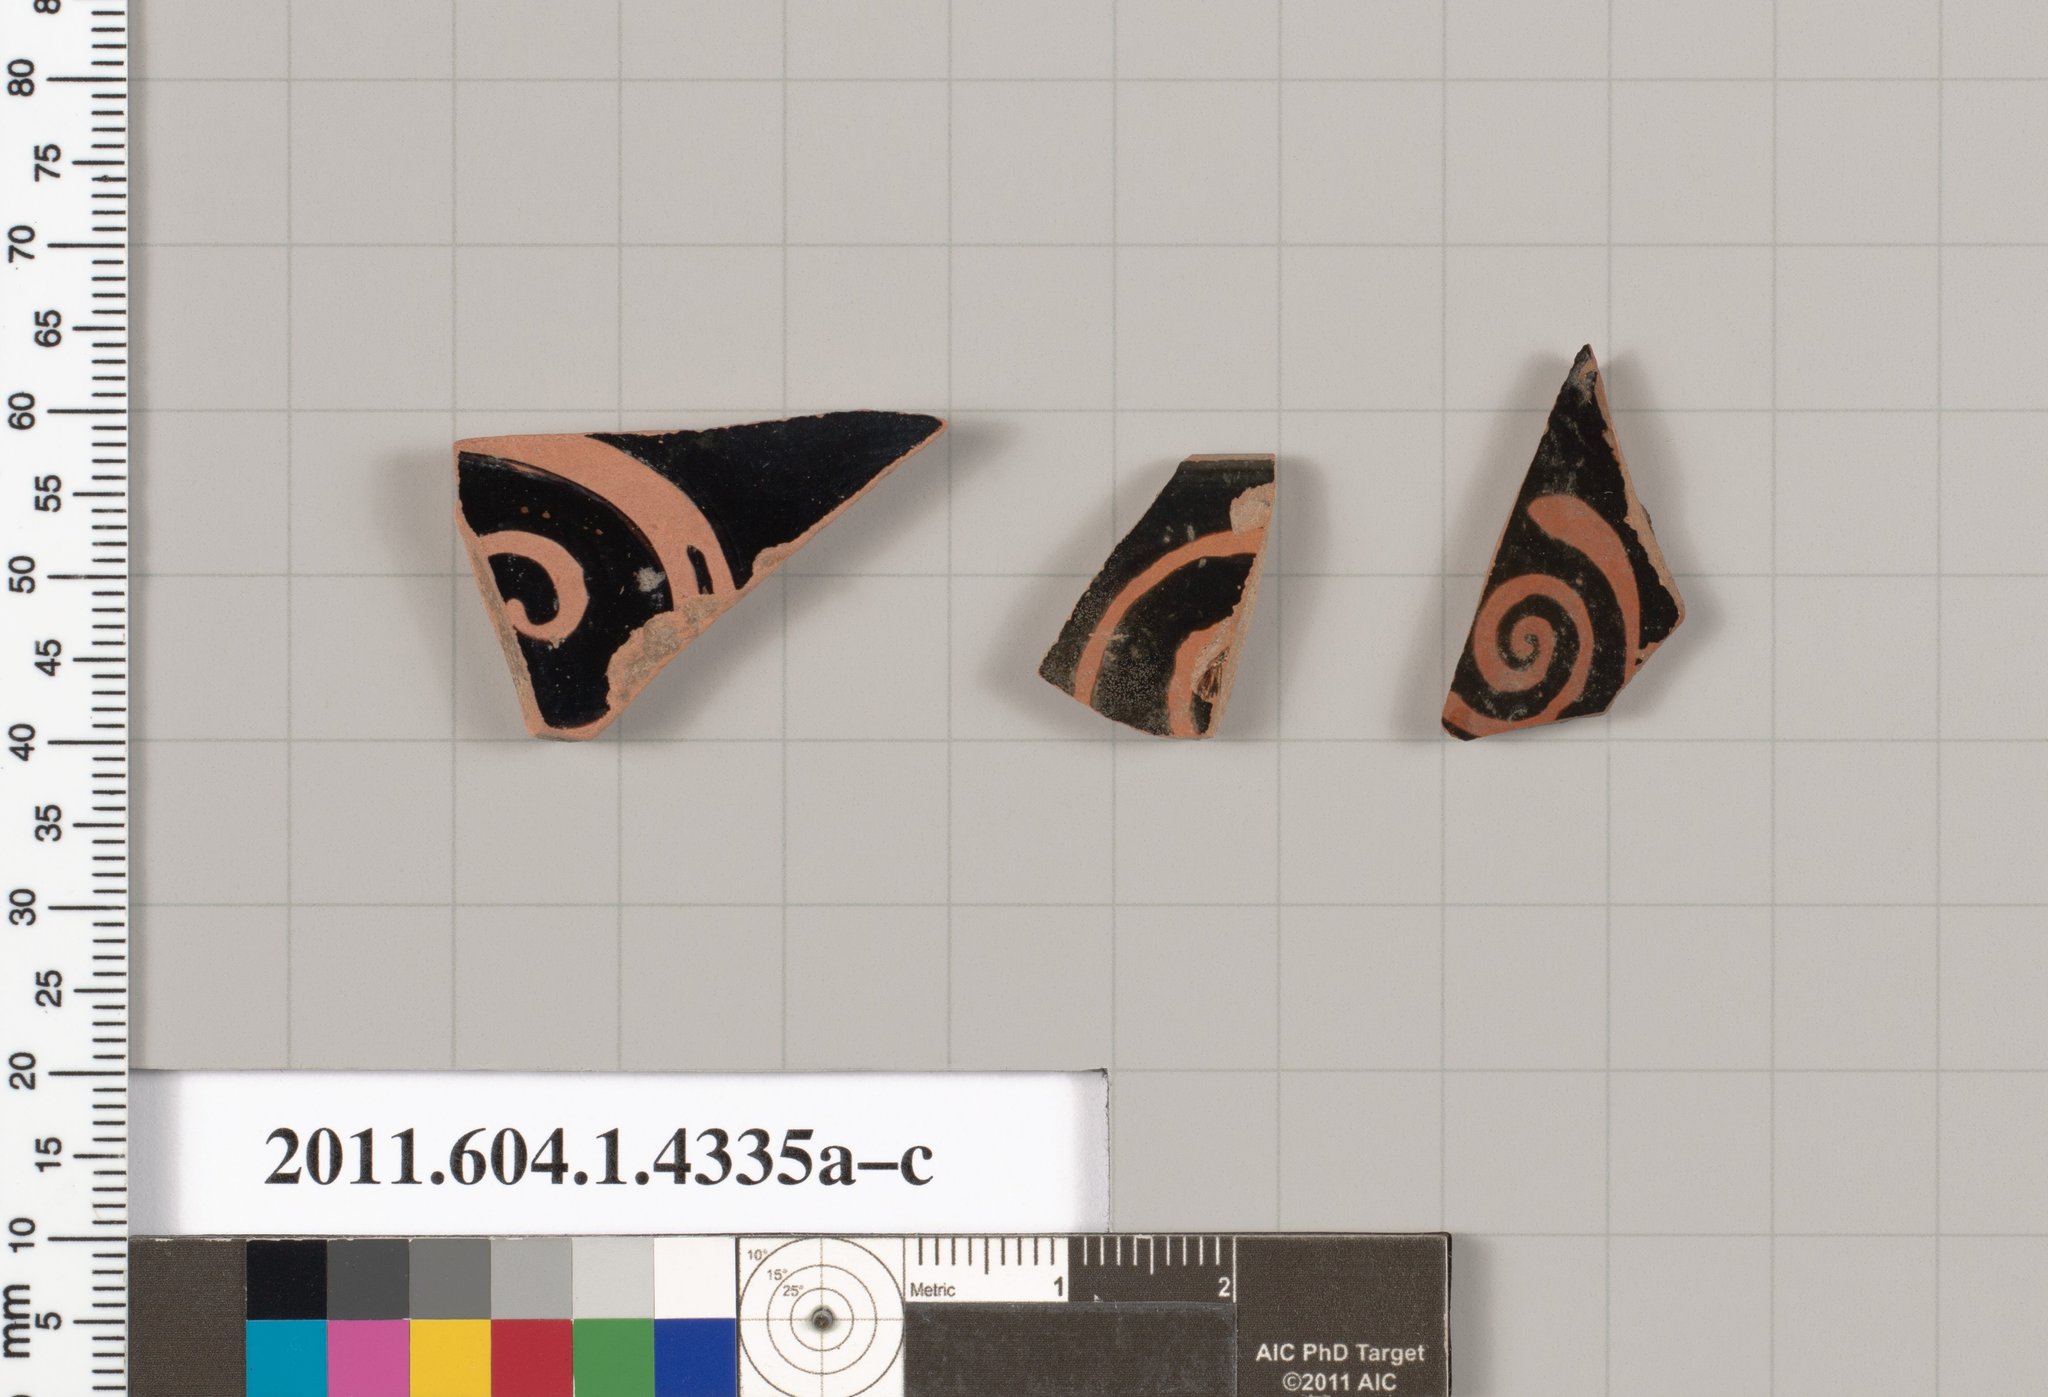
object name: kylix fragment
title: Terracotta fragments of kylikes (drinking cups)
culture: greek, attic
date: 475-451 BCE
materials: terracotta